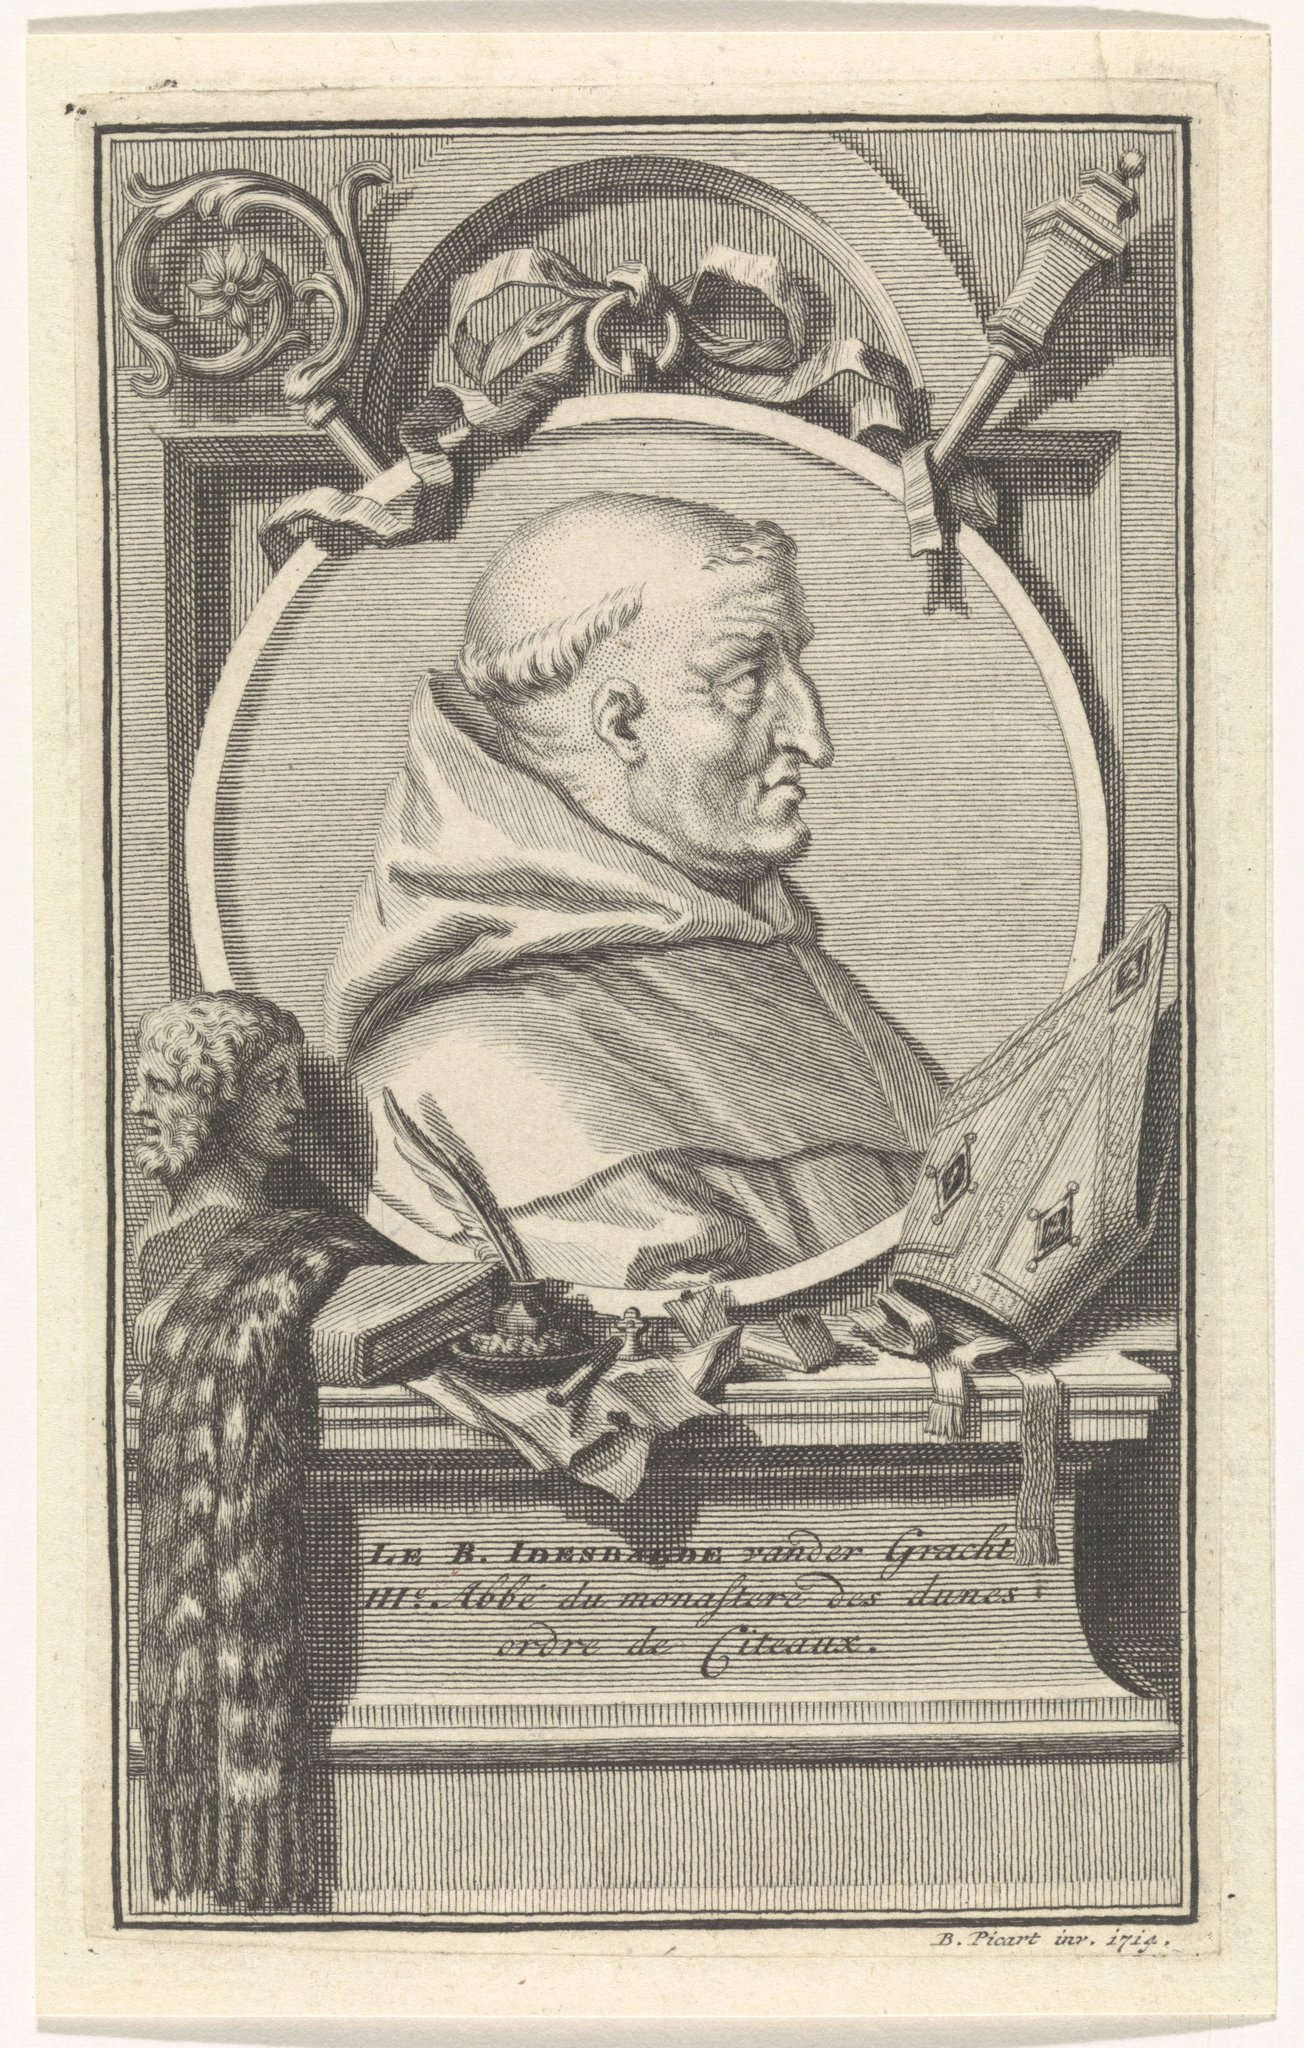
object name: print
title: Portret van de H. Idesbald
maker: bernard picart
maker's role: draughtsman, print maker, publisher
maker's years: 1673-1733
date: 1714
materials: paper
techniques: engraving, etching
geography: amsterdam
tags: writing tools, insignia of bishop, e.g. mitre, crozier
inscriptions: collector's mark: Lugt 2228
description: Portret van Idesbald Van der Gracht, monnik, kanunnik en Vlaamse heilige. Op de piëdestal de bisschopsmijter, een inktpot met schrijfveer, en een Januskop.